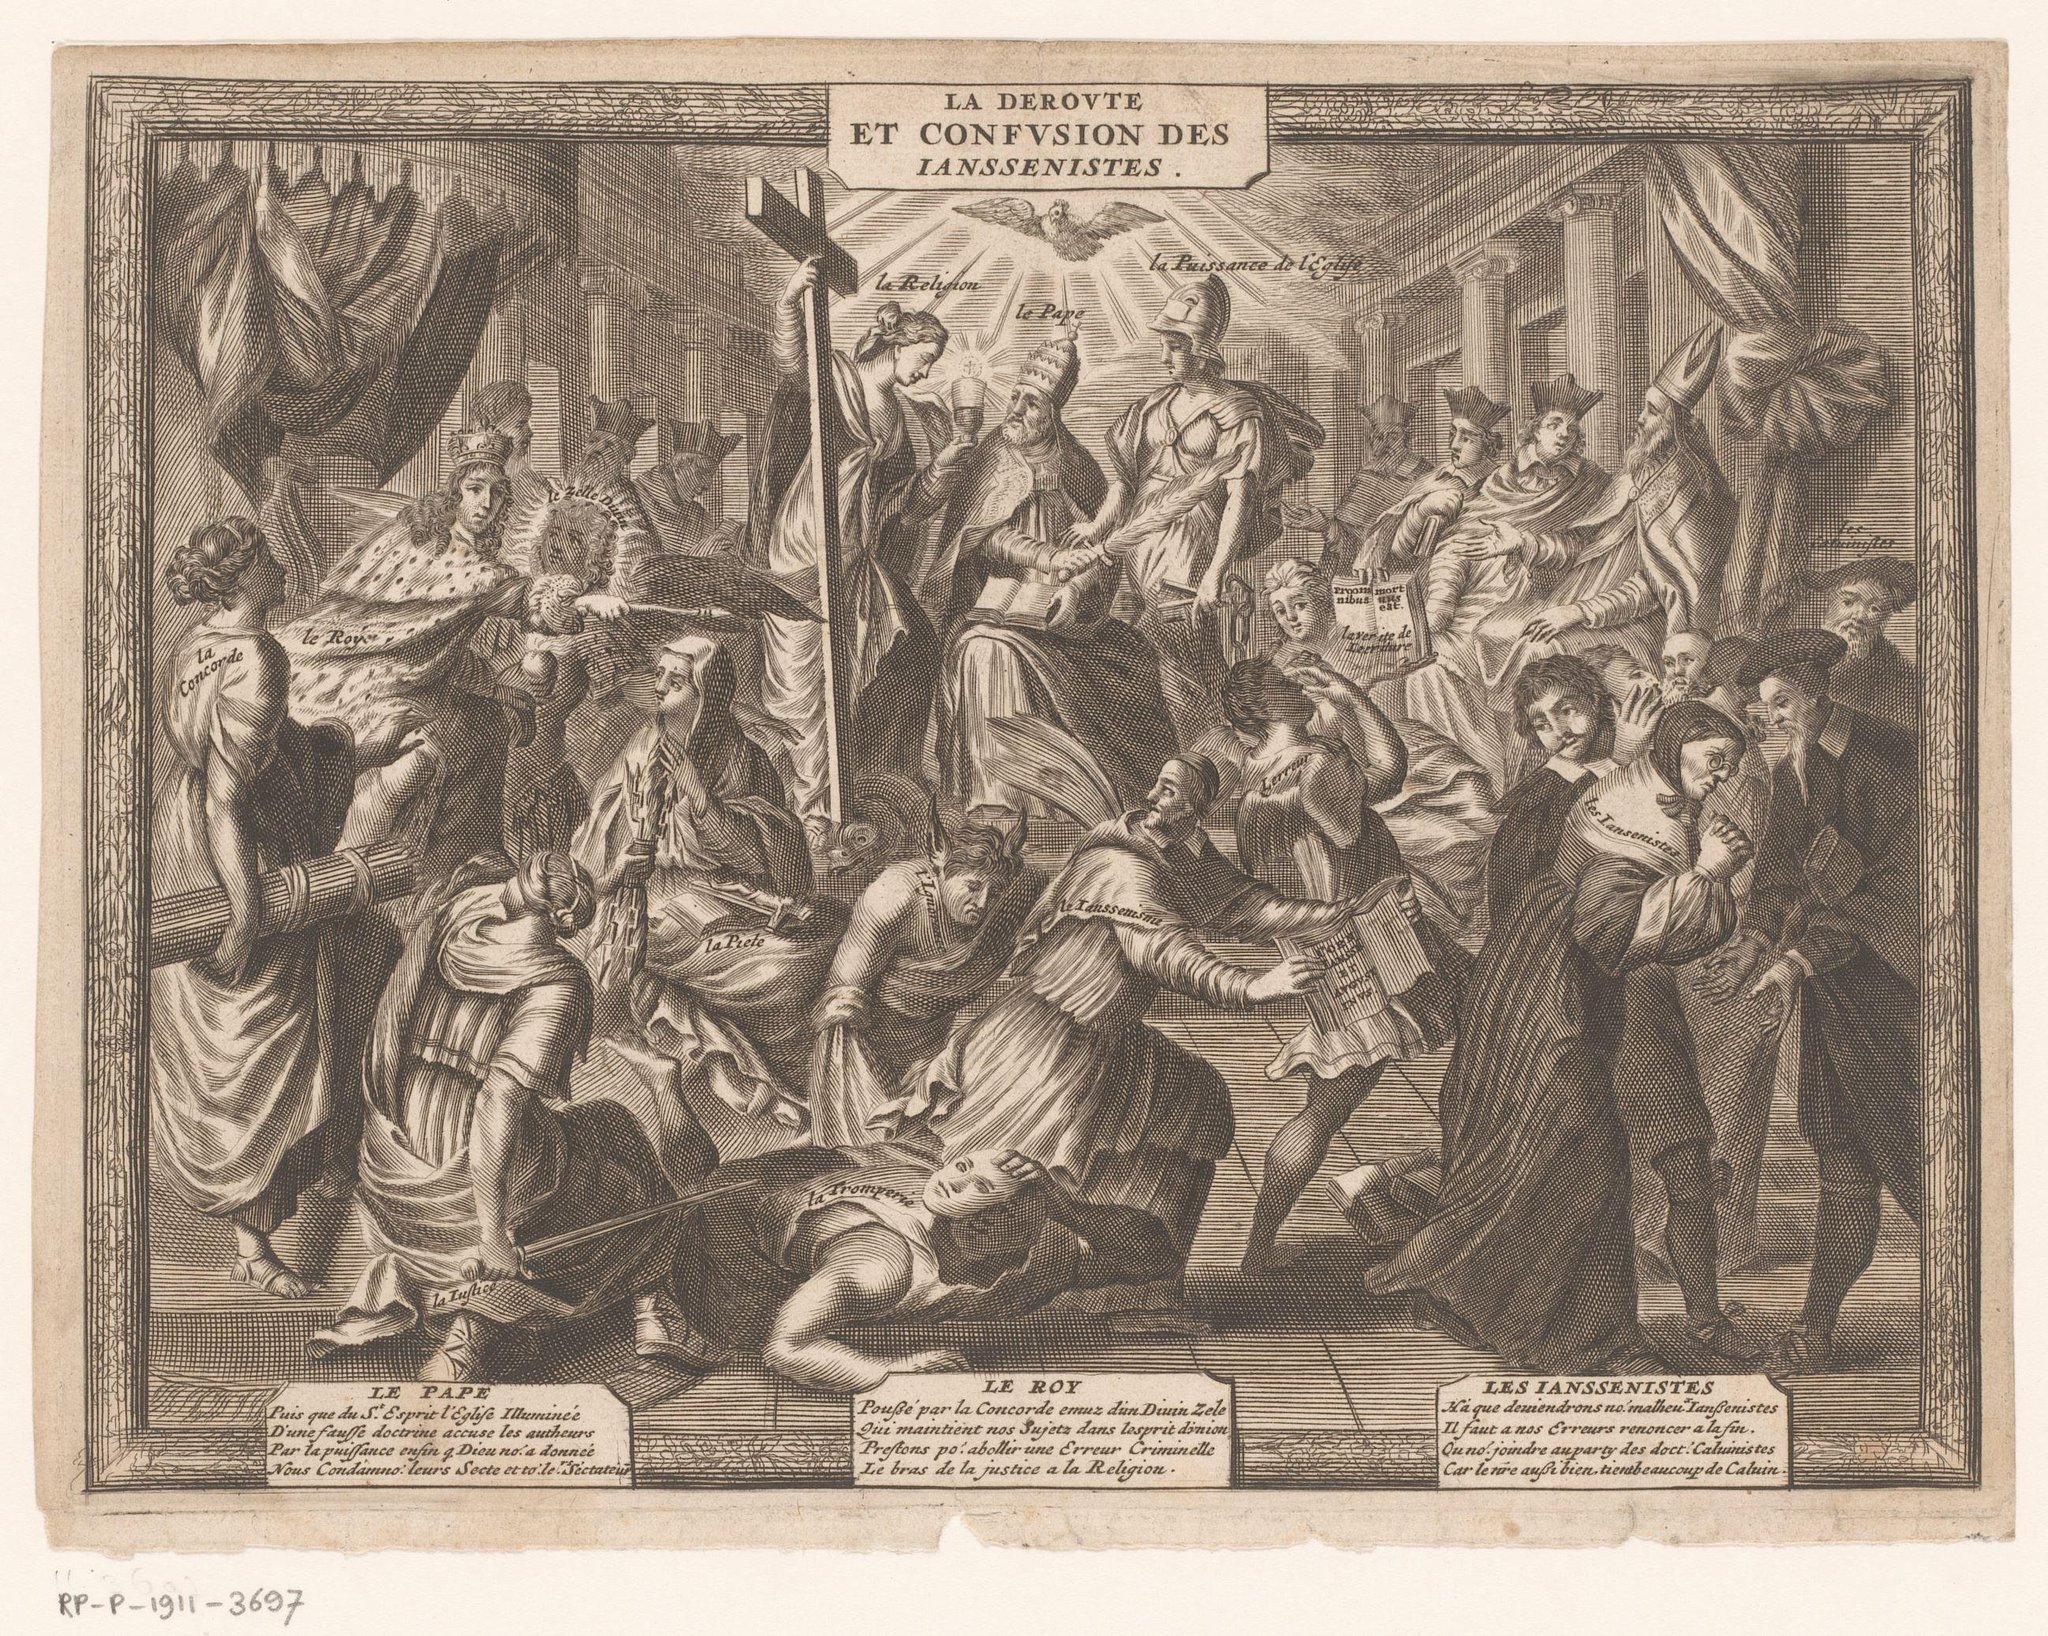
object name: print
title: La Deroute et Confusion des Ianssenistes.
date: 1630-1690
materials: paper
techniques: engraving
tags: suspension, expulsion (from a society), pope, king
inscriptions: collector's mark: Lugt 2228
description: De Paus midden boven wordt geflankeerd door de allegorische figuren Religie en de Kerkelijke macht. Boven hem vliegt de Heilige Geest. Links zit de koning op een troon met naast hem de Goddelijke ijver, de Eendracht, de Gerechtigheid en de Vroomheid. De koning verbant de allegorische figuren Onwetendheid, Misverstand en Misleiding met in het midden Het Jansenisme met in zijn handen 'De Augustinus', voorgegaan door Jansenisten.